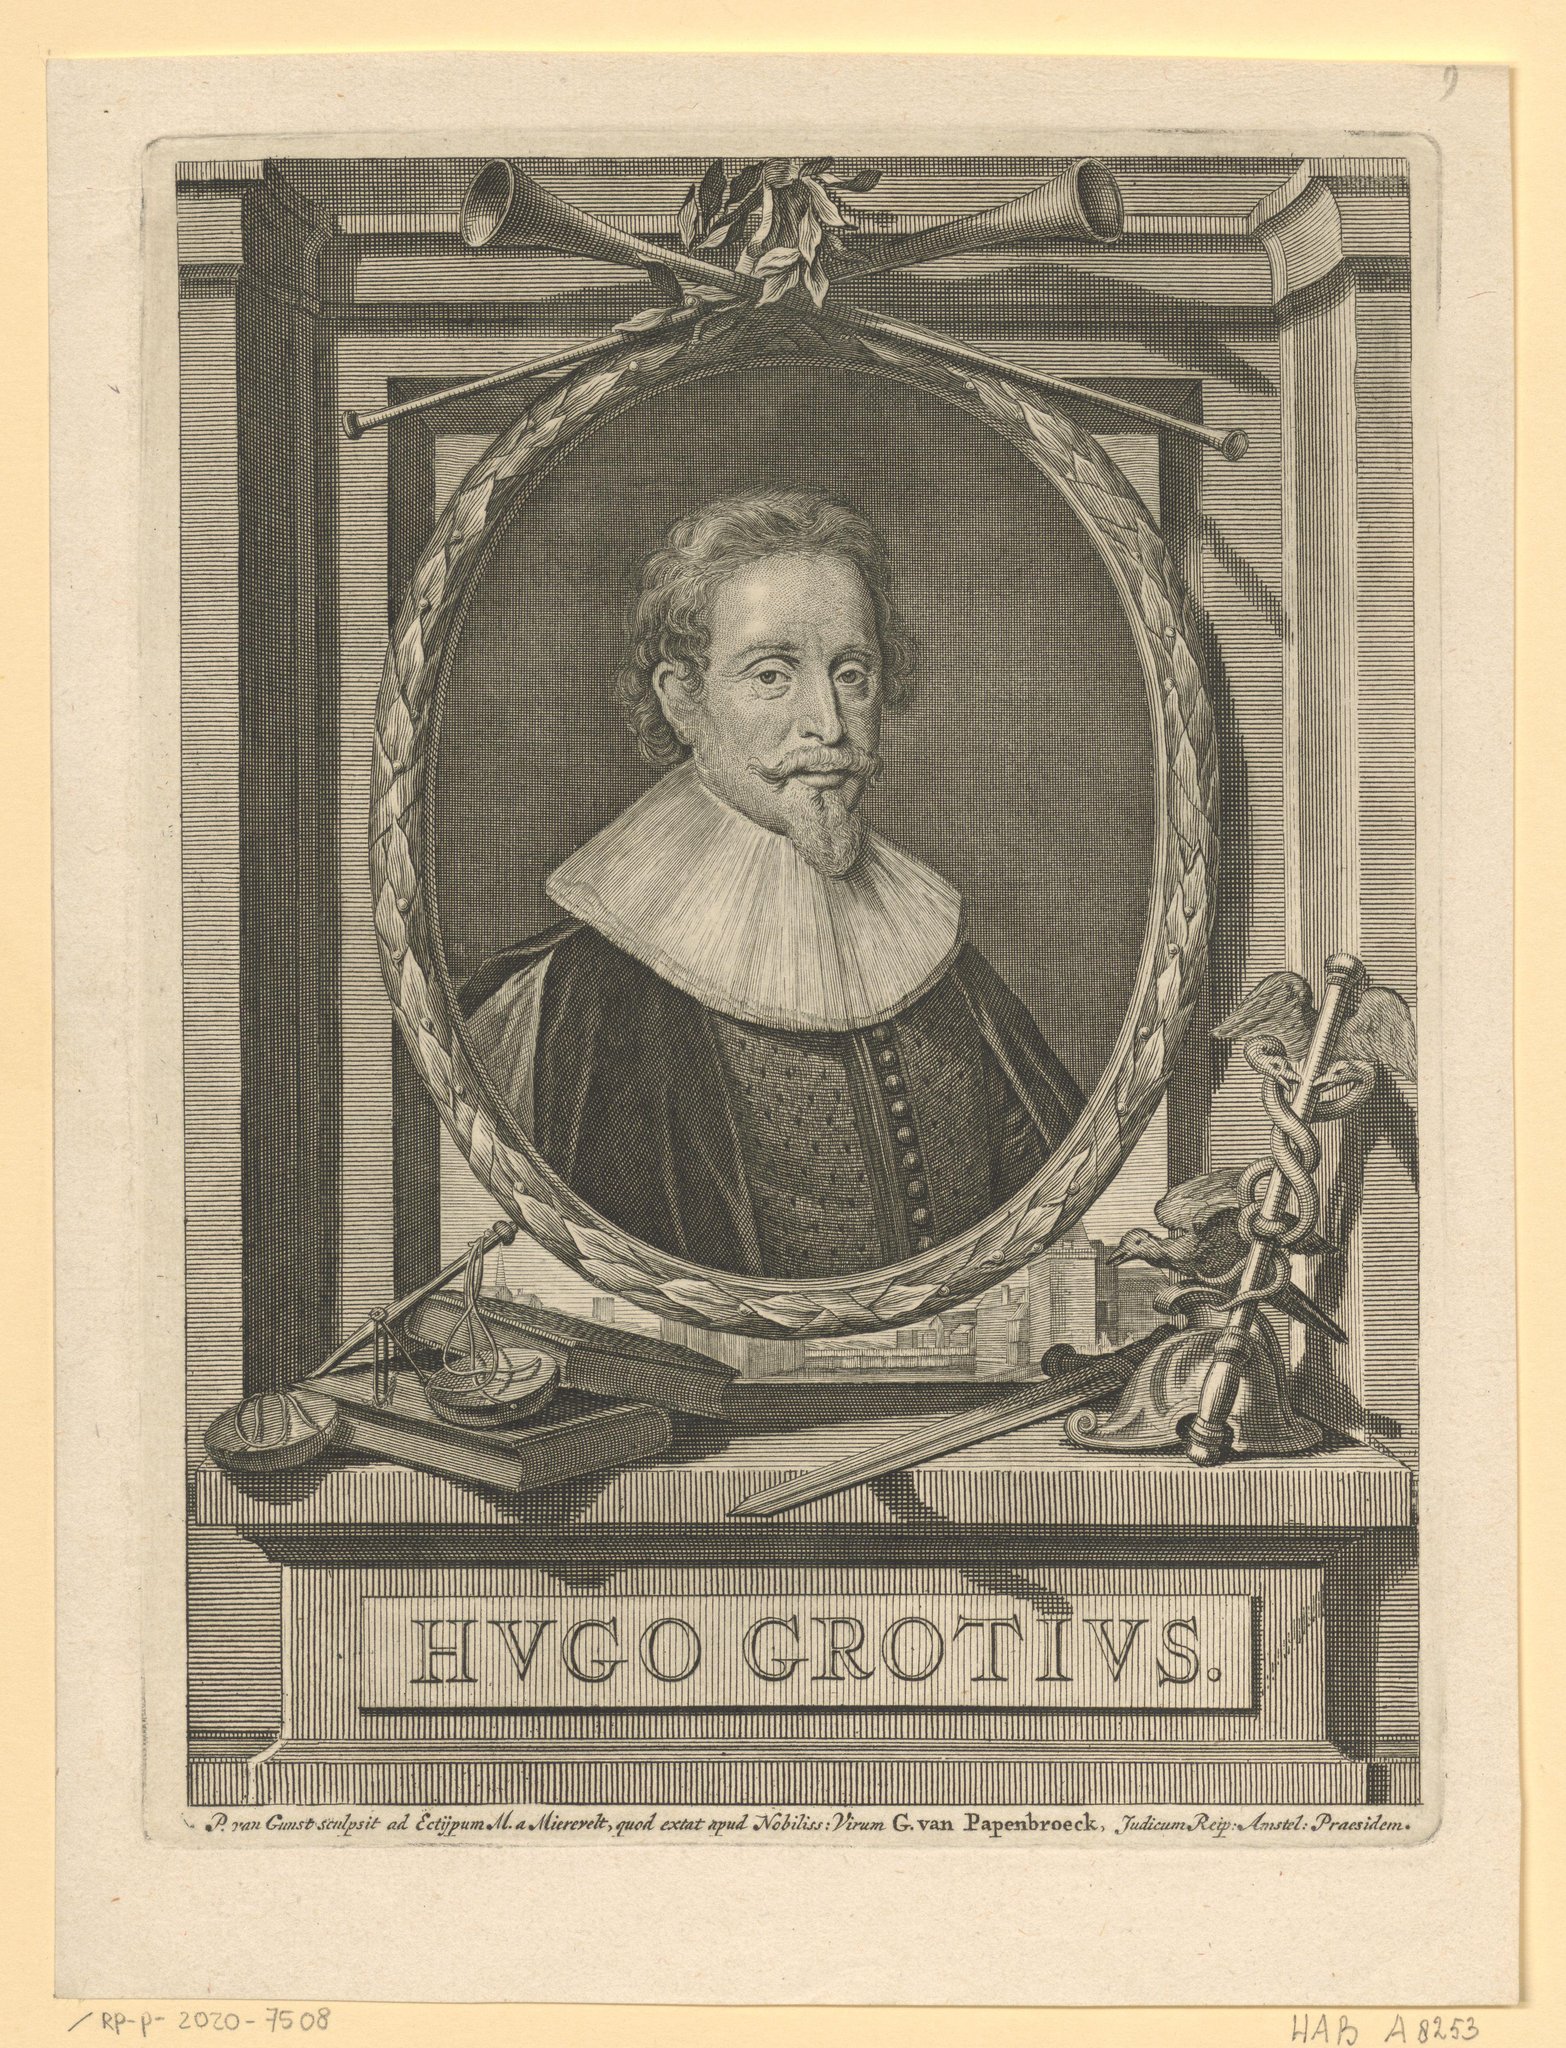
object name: print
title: Portret van Hugo de Groot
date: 1710-1731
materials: paper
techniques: engraving, etching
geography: amsterdam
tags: delft, hugo de groot, historical persons, scales, portrait of a writer